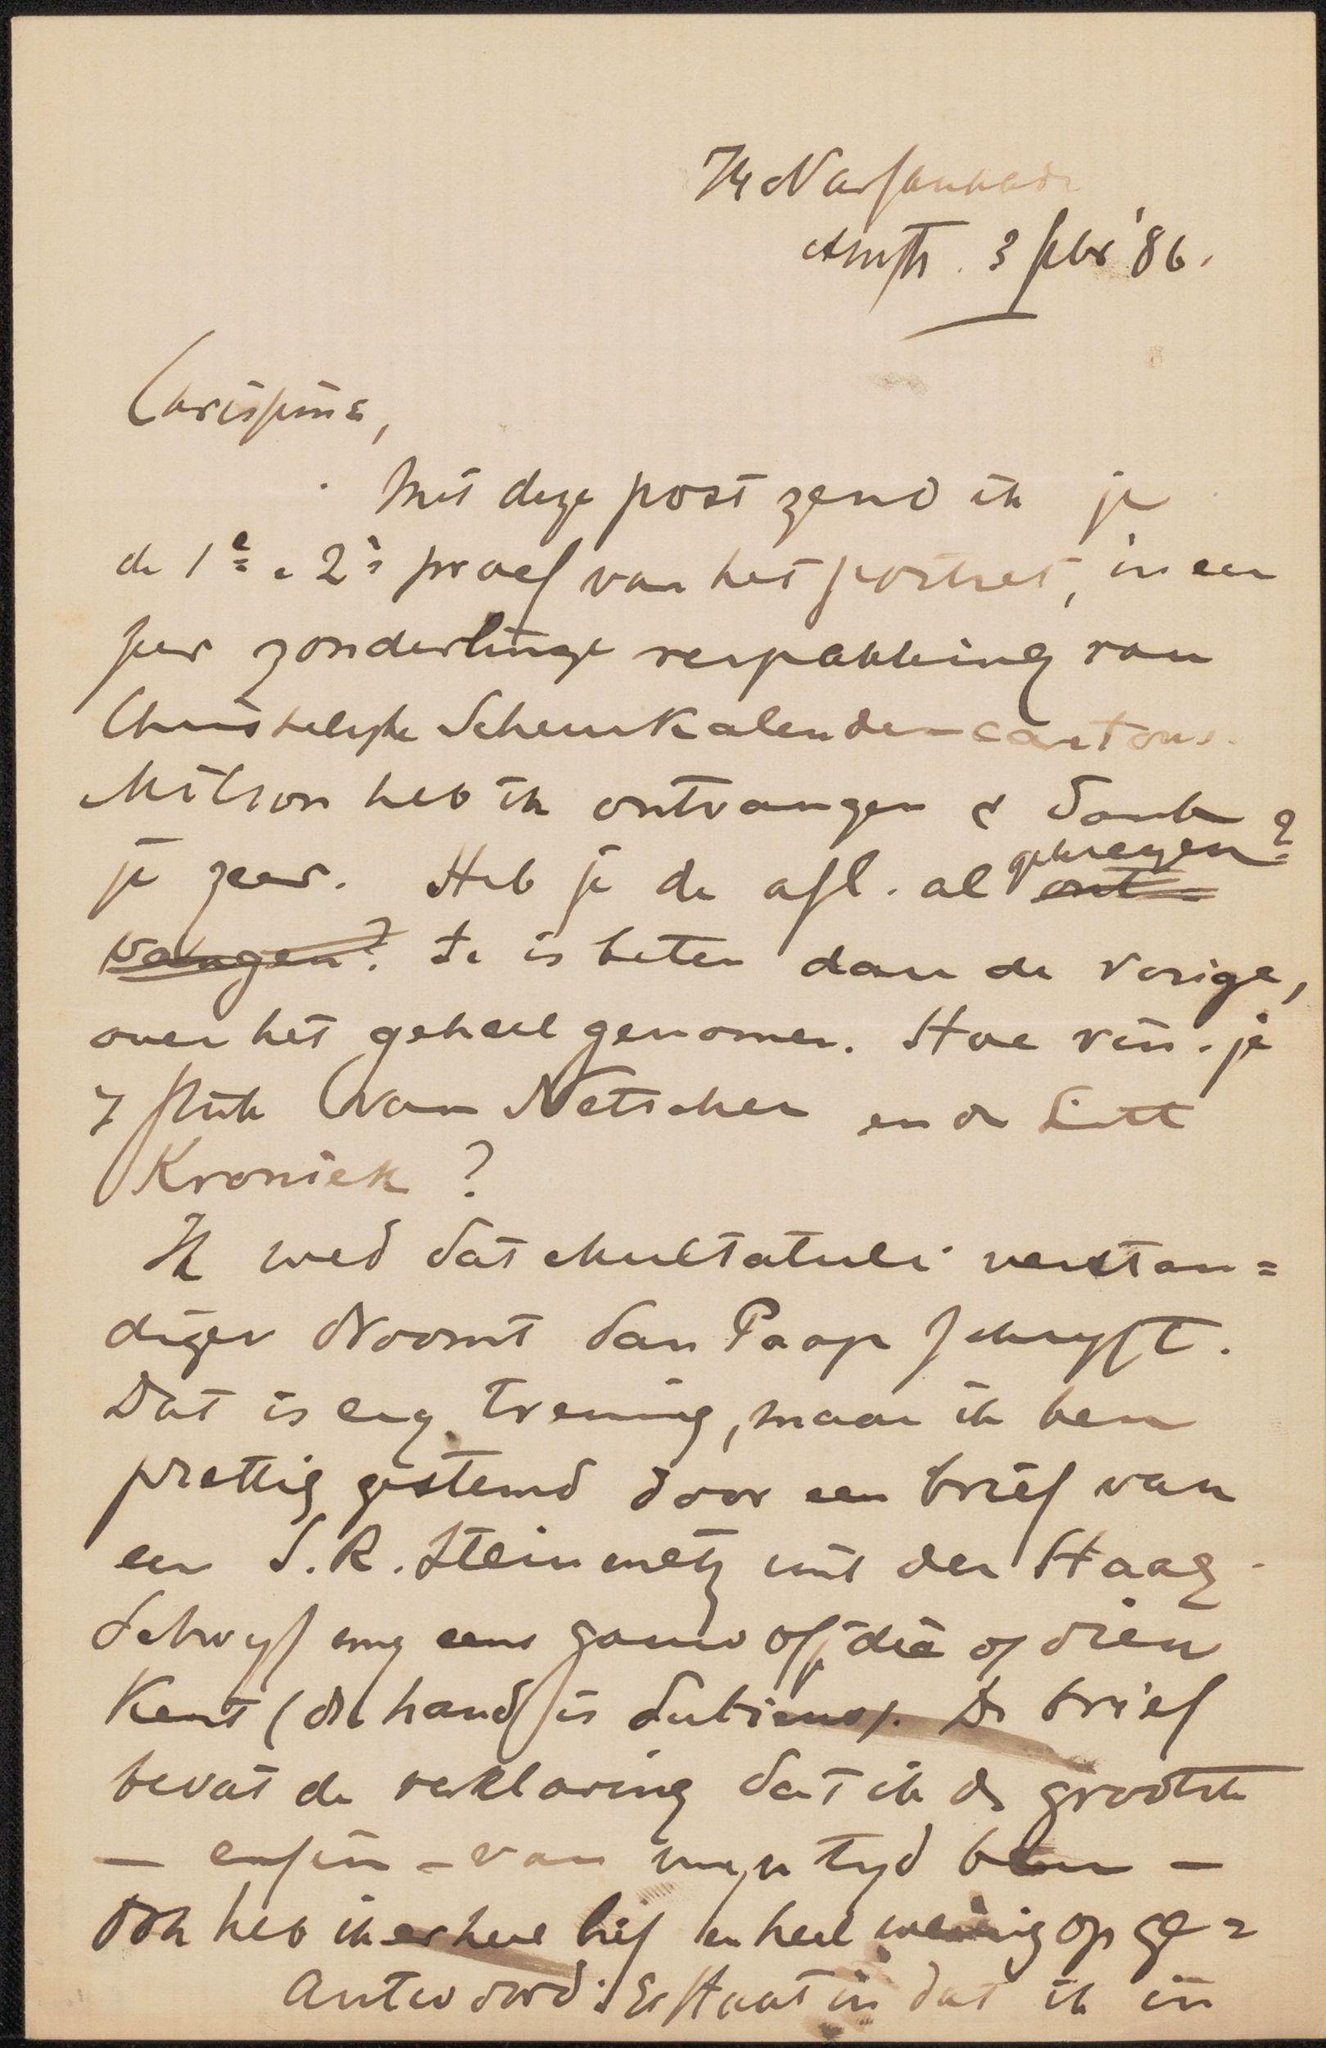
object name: letter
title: Brief aan Jan Veth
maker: albert verwey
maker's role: criticus, dichter, essayist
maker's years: 1865-1937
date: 1886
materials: ink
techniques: pen, writing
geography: amsterdam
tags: designer, jan veth, painter, draughtsman, jac van looij, multatuli, willem kloos, zeist, the hague, haarlem, frans netscher, historical persons (portraits and scenes from the life), amsterdam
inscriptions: collector's mark: ‘RPK’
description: Opgenomen in: Verwey, Albert, Margaretha H. Schenkeveld, Rein van der Wiel: Briefwisseling 1 juli 1885 tot 15 december 1888, Amsterdam: EM. Querido's Uitgeverij B.V., 1993, p. 133.